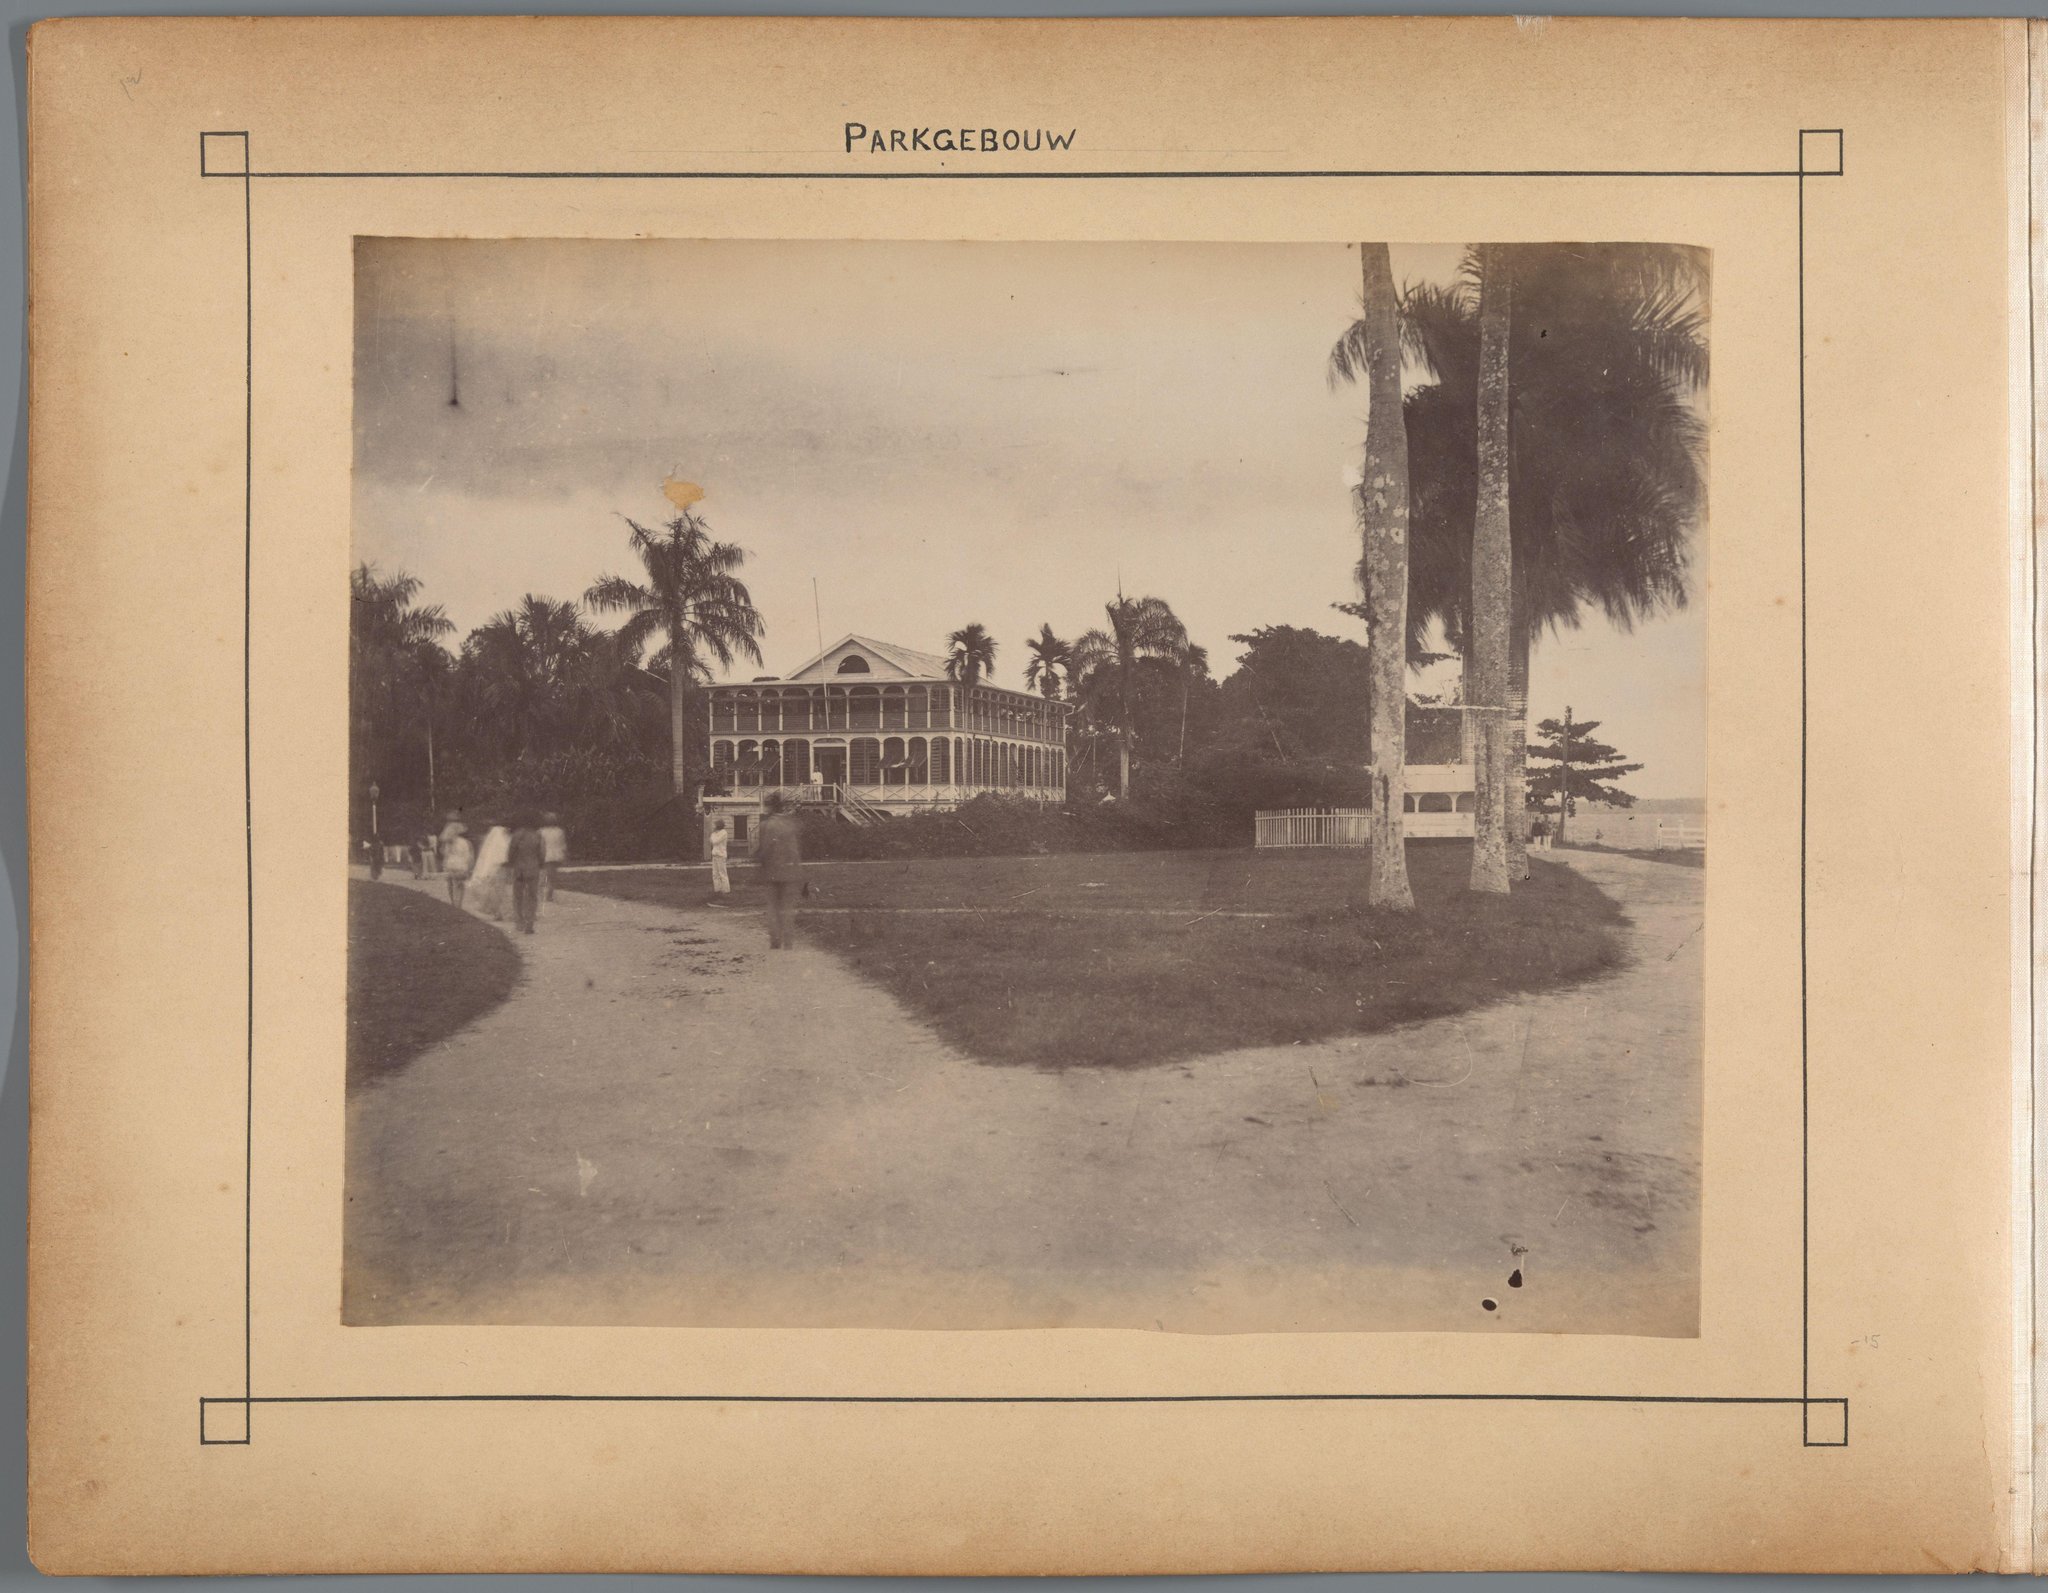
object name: photograph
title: Parkgebouw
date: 1898-1902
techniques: albumen print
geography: suriname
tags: suriname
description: De buitensociëteit 'Het Park' in Paramaribo.